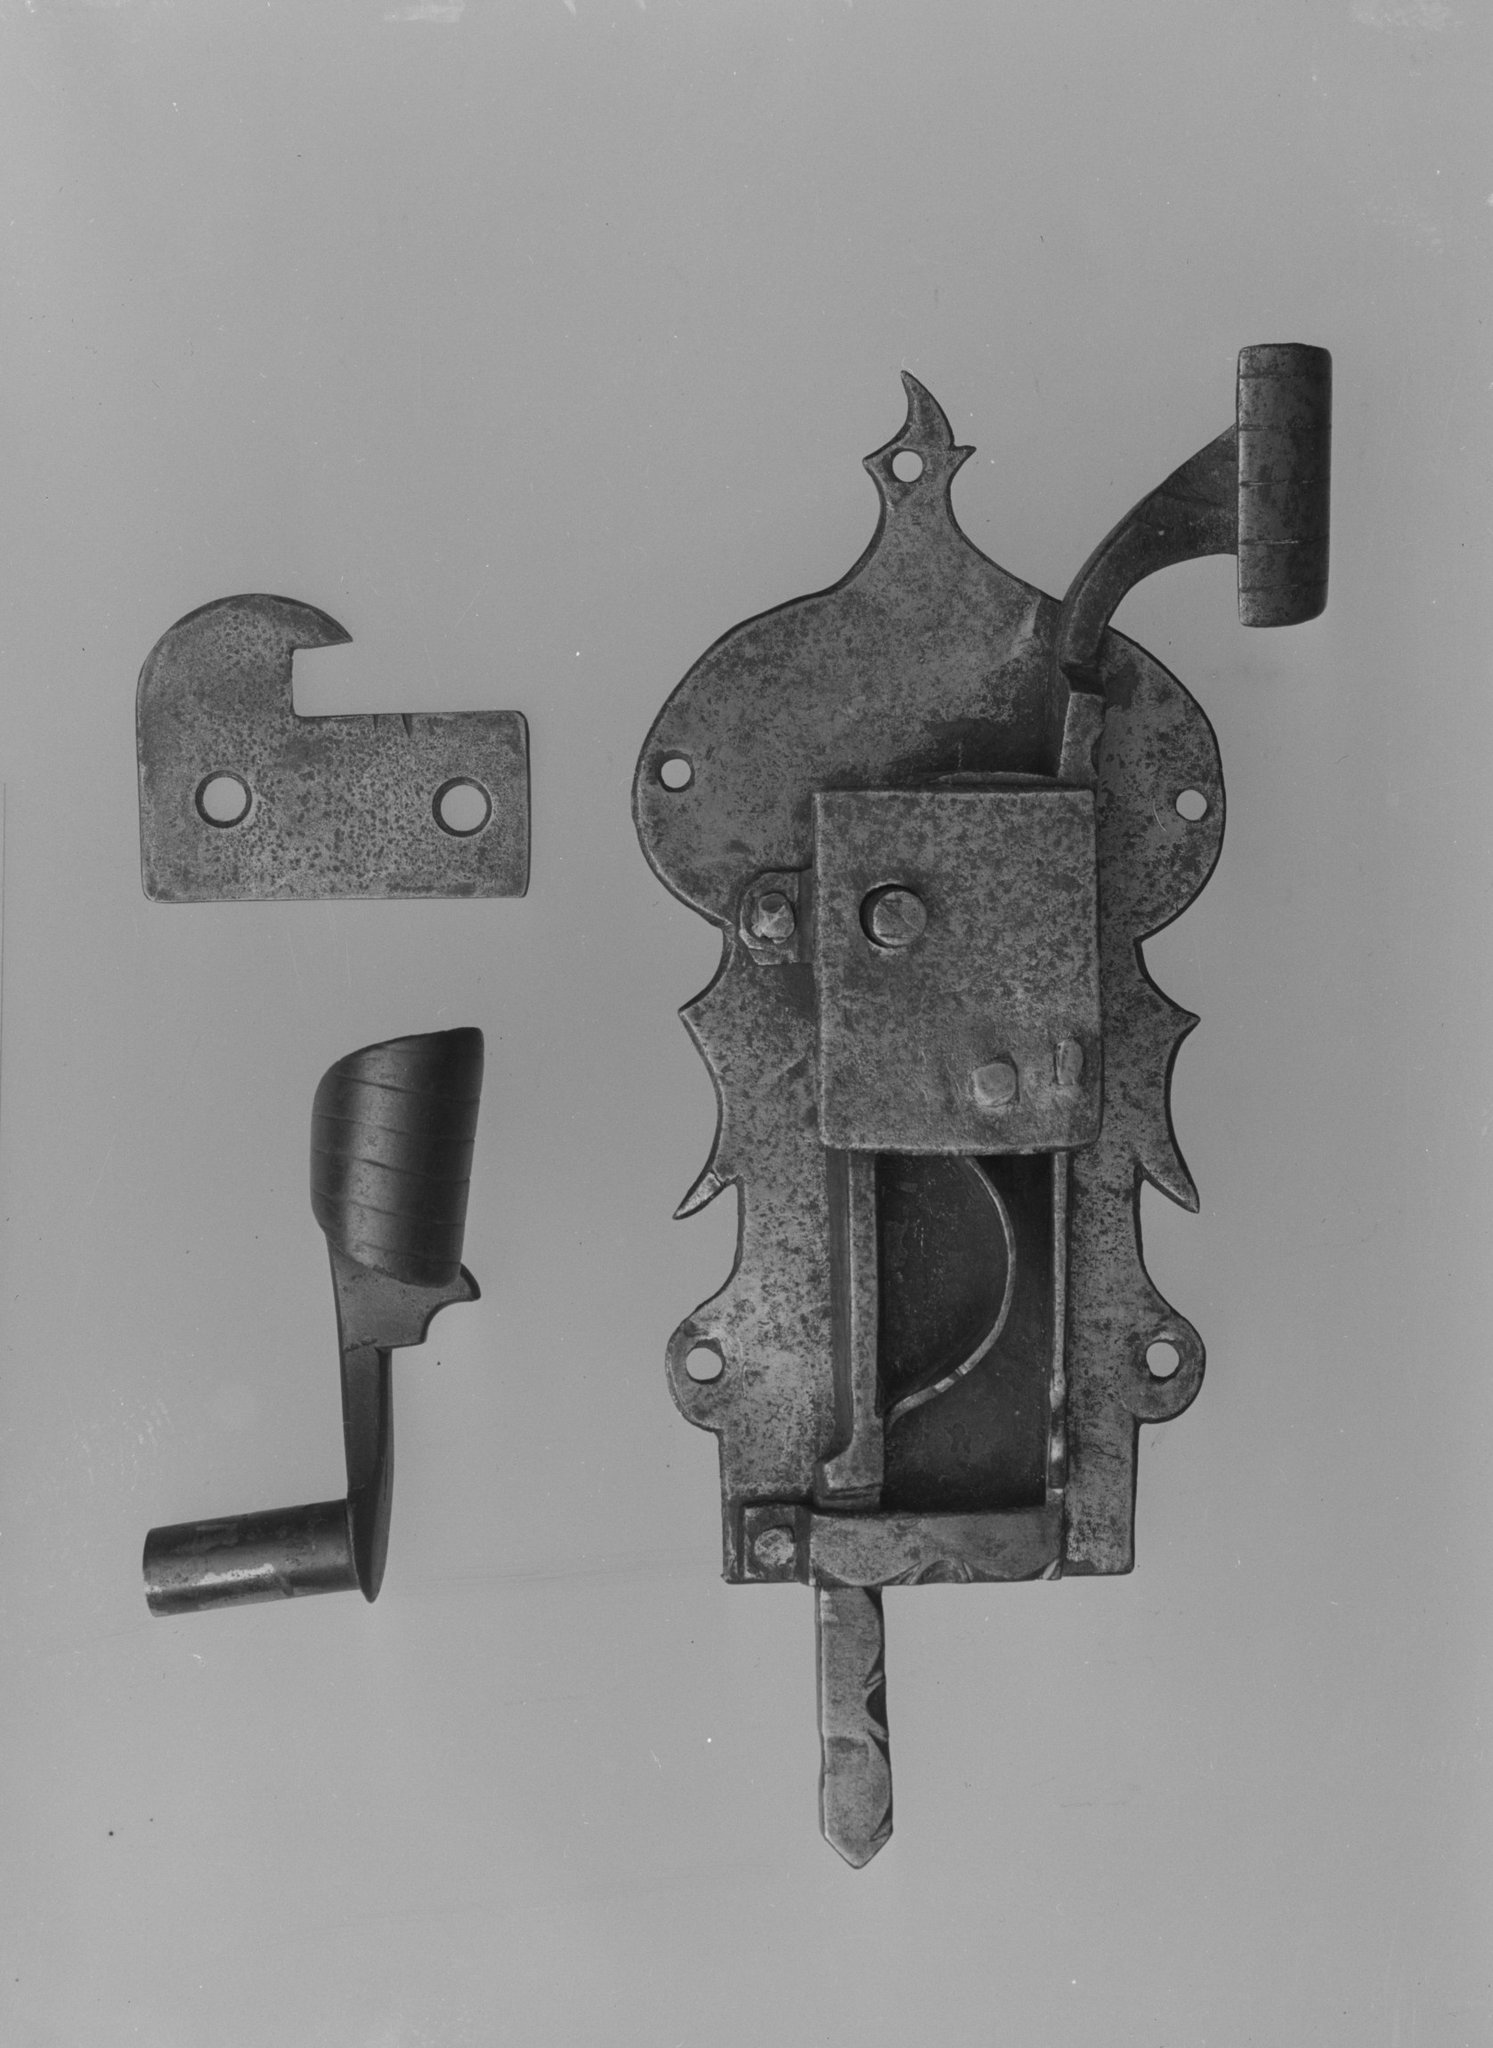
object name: latch lock, key, and catch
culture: american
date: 1700-1800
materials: iron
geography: united states